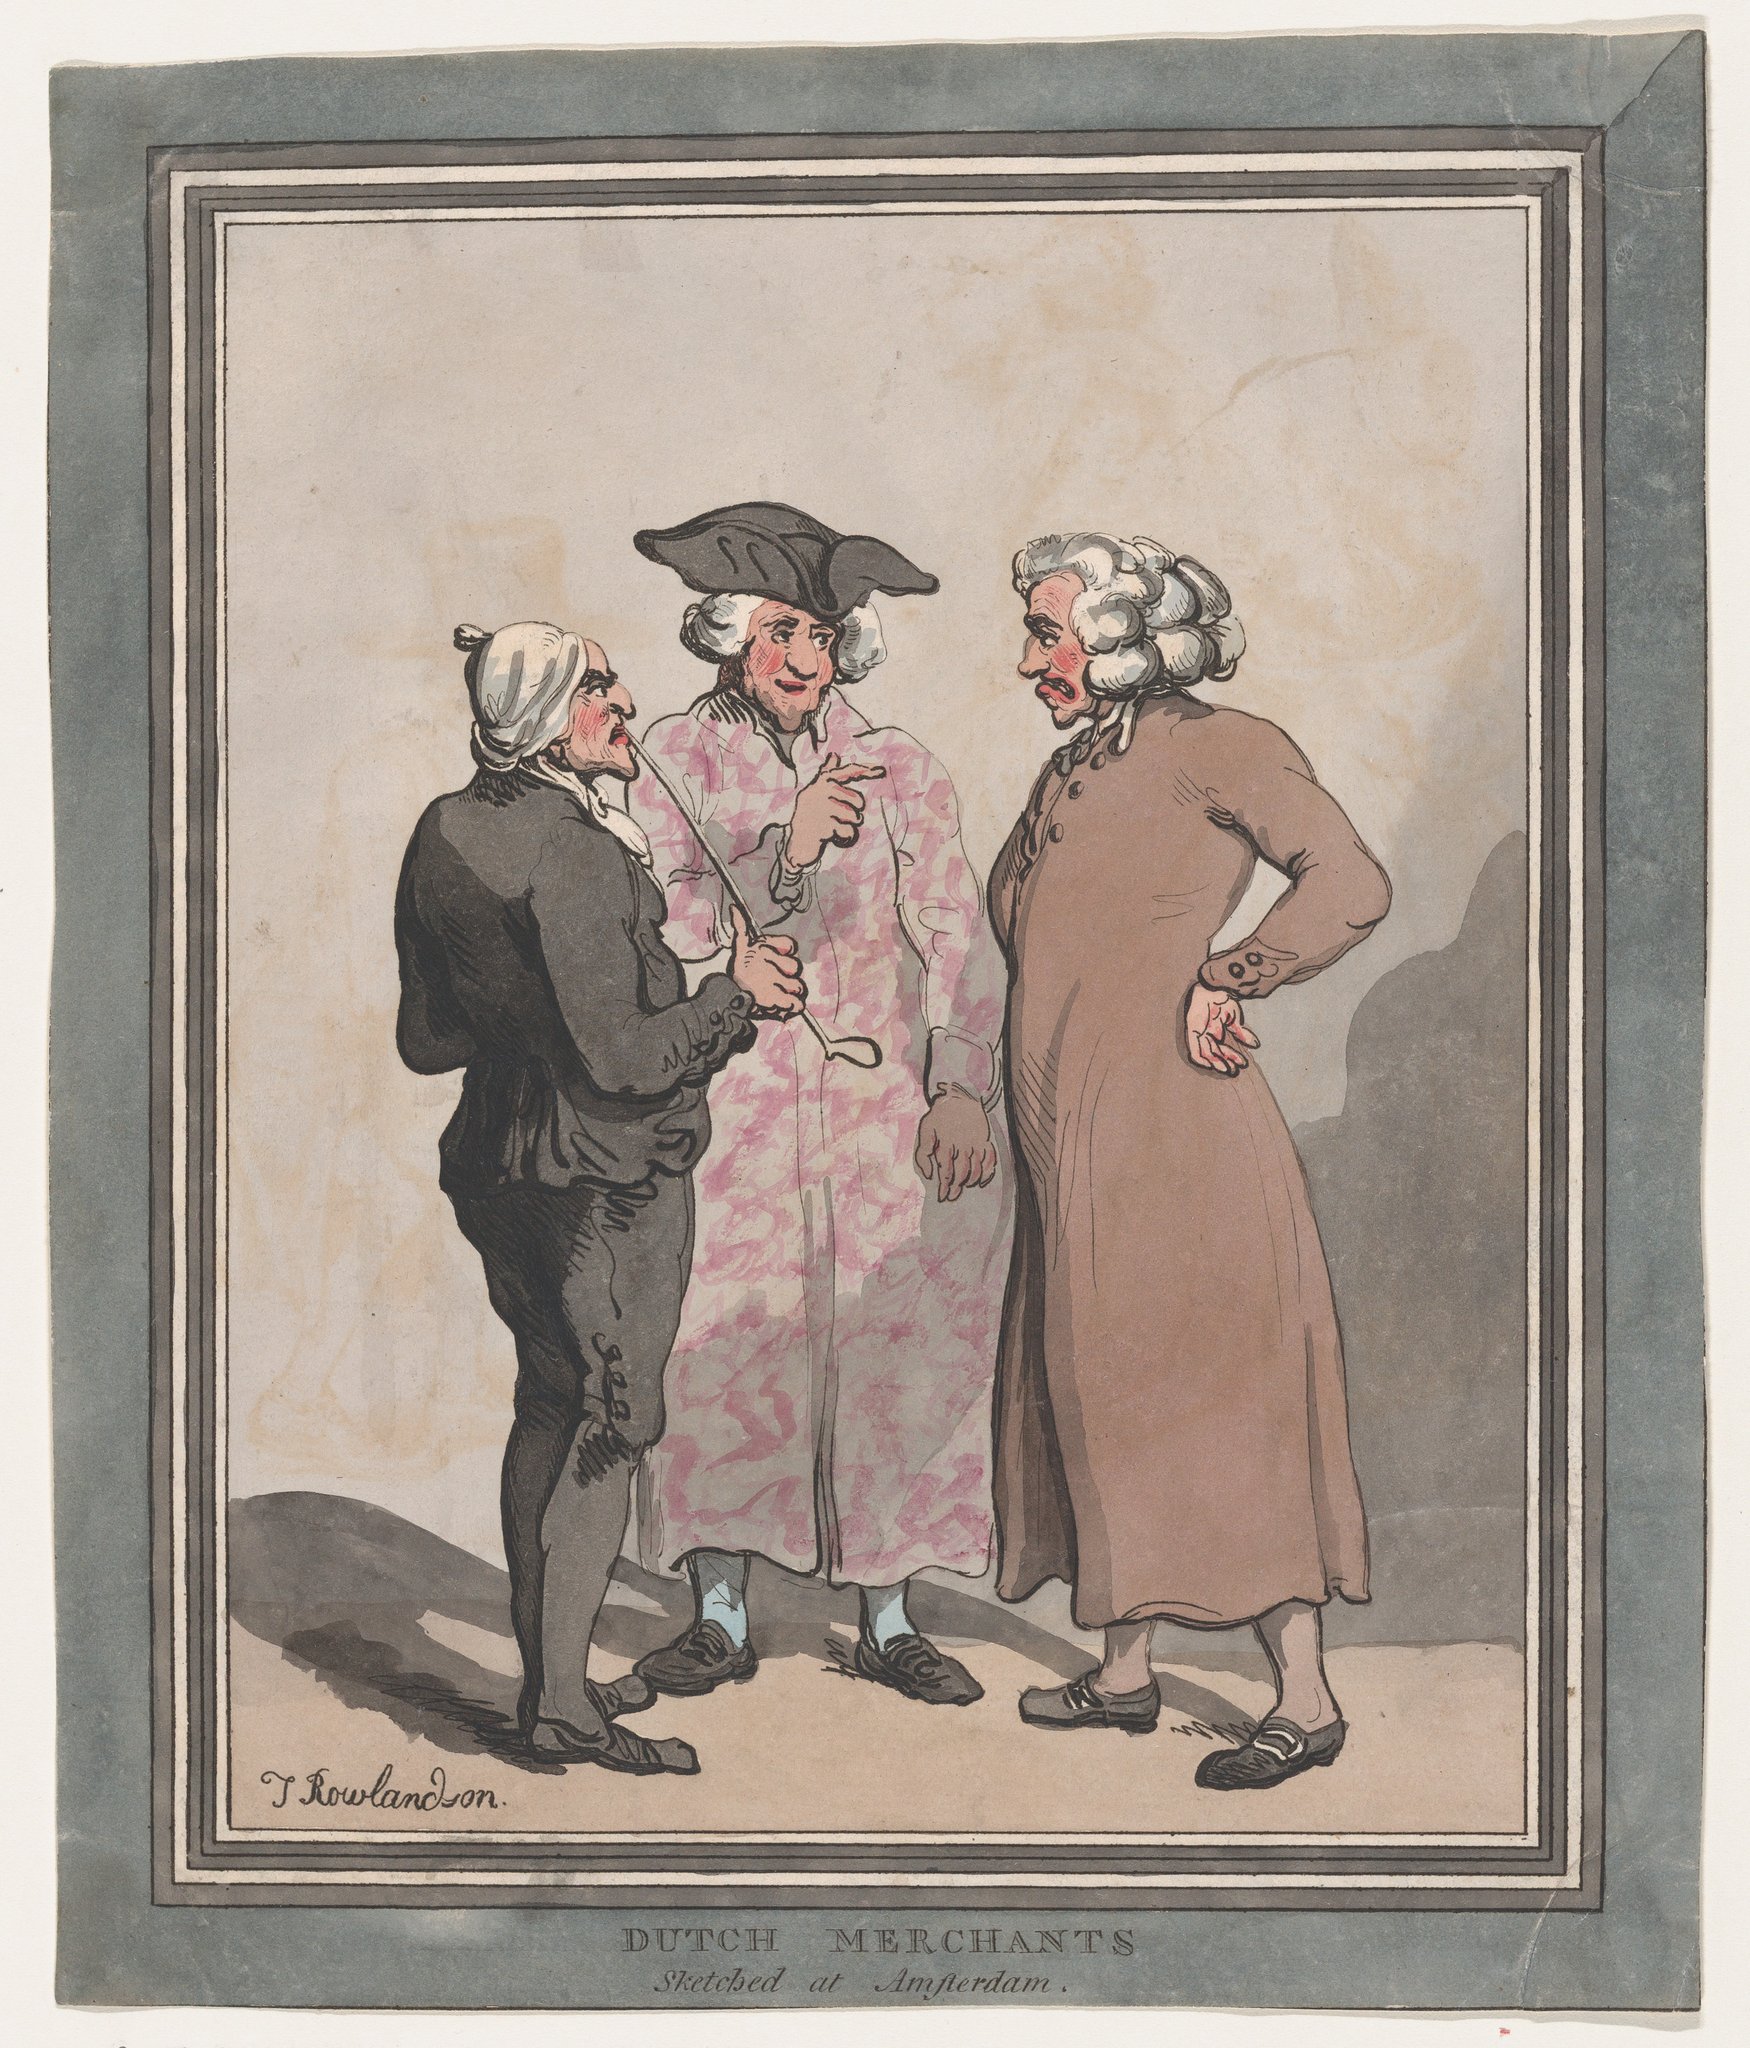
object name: print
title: Dutch Merchants Sketched at Amsterdam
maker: thomas rowlandson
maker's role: artist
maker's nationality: british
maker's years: 1757-1827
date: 1796-1797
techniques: etching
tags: men,merchants